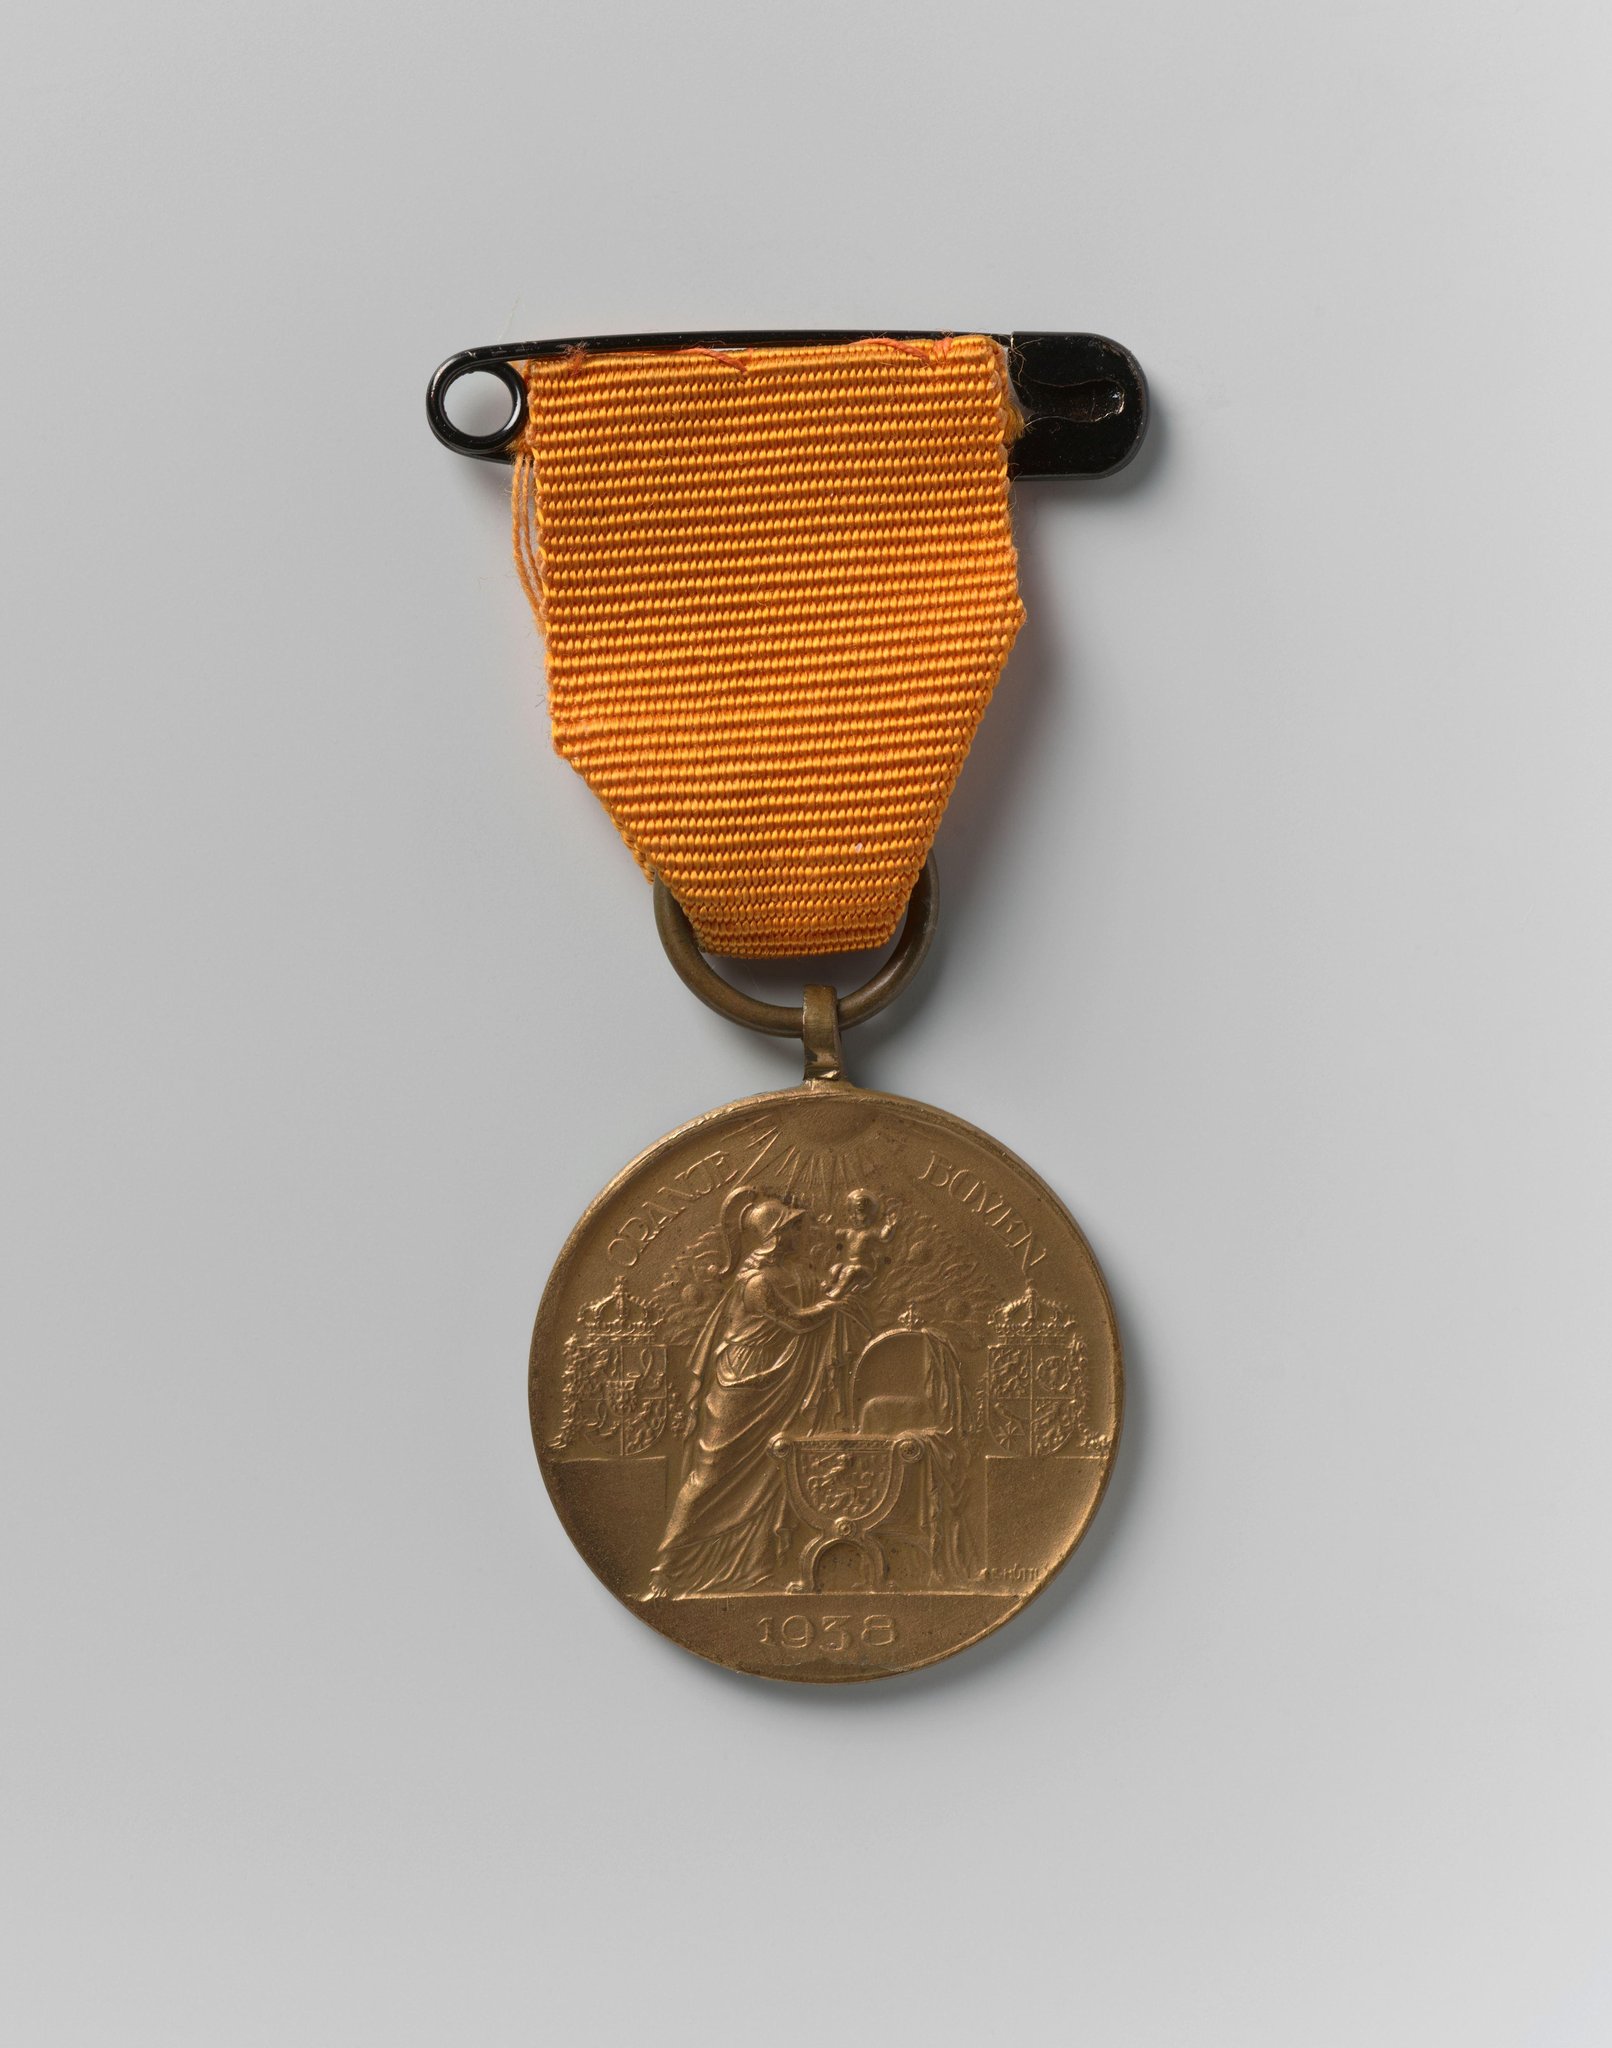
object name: insignia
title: Draagpenning over de geboorte van Prinses Beatrix 1938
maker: eduard hüttl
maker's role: graveur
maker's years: 1893-1938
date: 1938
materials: bronze, textile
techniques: striking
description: Messing penning met oog en draagring aan een oranje lint met veiligheidsspeld, op de voorzijde de Nederlandse Maagd die een pasgeborene onder een stralende zon boven een wieg houdt, tussen oranjeloof en de wapenschilden van Koningin Wilhemina en Prins Bernhard, met omschrift bovenaan en afsnedetekst, op de keerzijde het aanzicht van Paleis Soestdijk met bovenaan omschrift en onderaan het gekroonde Nederlandse wapenschild met dragers.